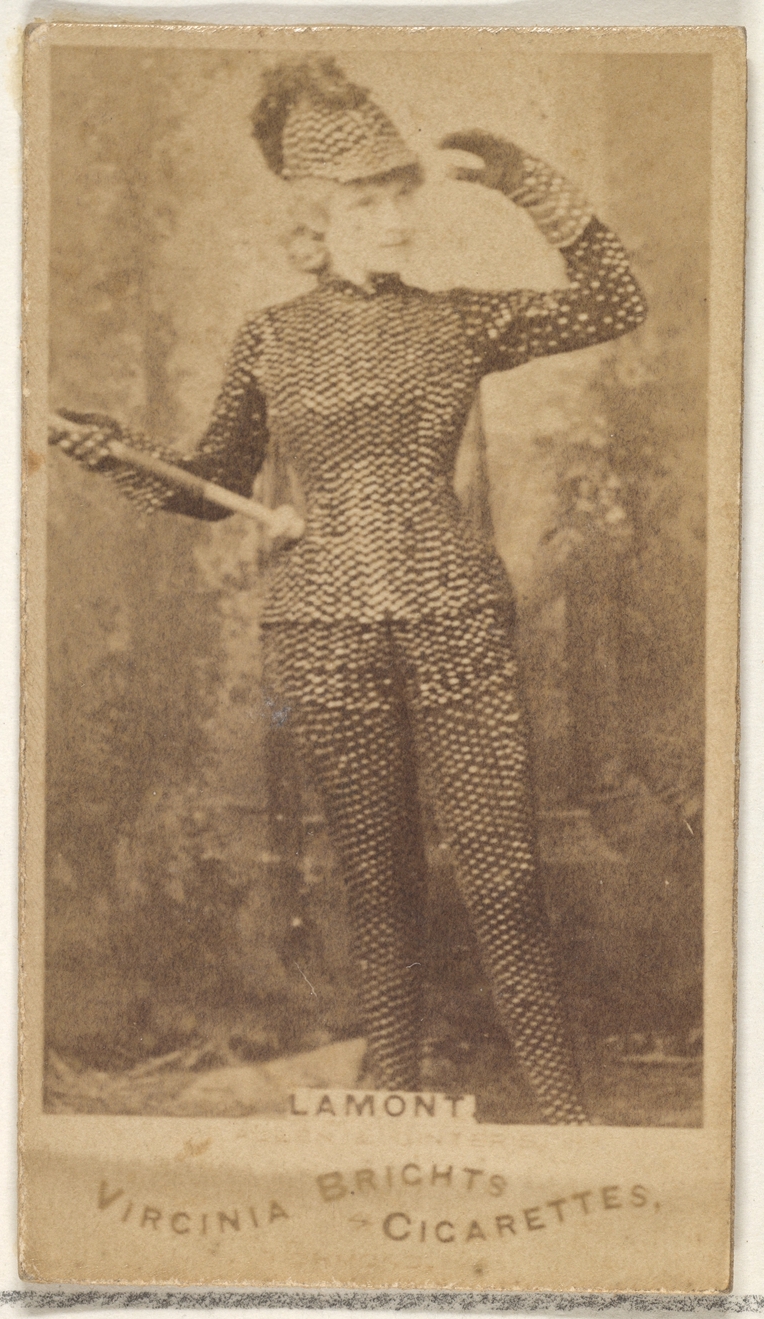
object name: photograph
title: Lamont, from the Actors and Actresses series (N45, Type 1) for Virginia Brights Cigarettes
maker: allen & ginter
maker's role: publisher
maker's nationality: american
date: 1888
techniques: albumen silver print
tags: portraits,women,actresses